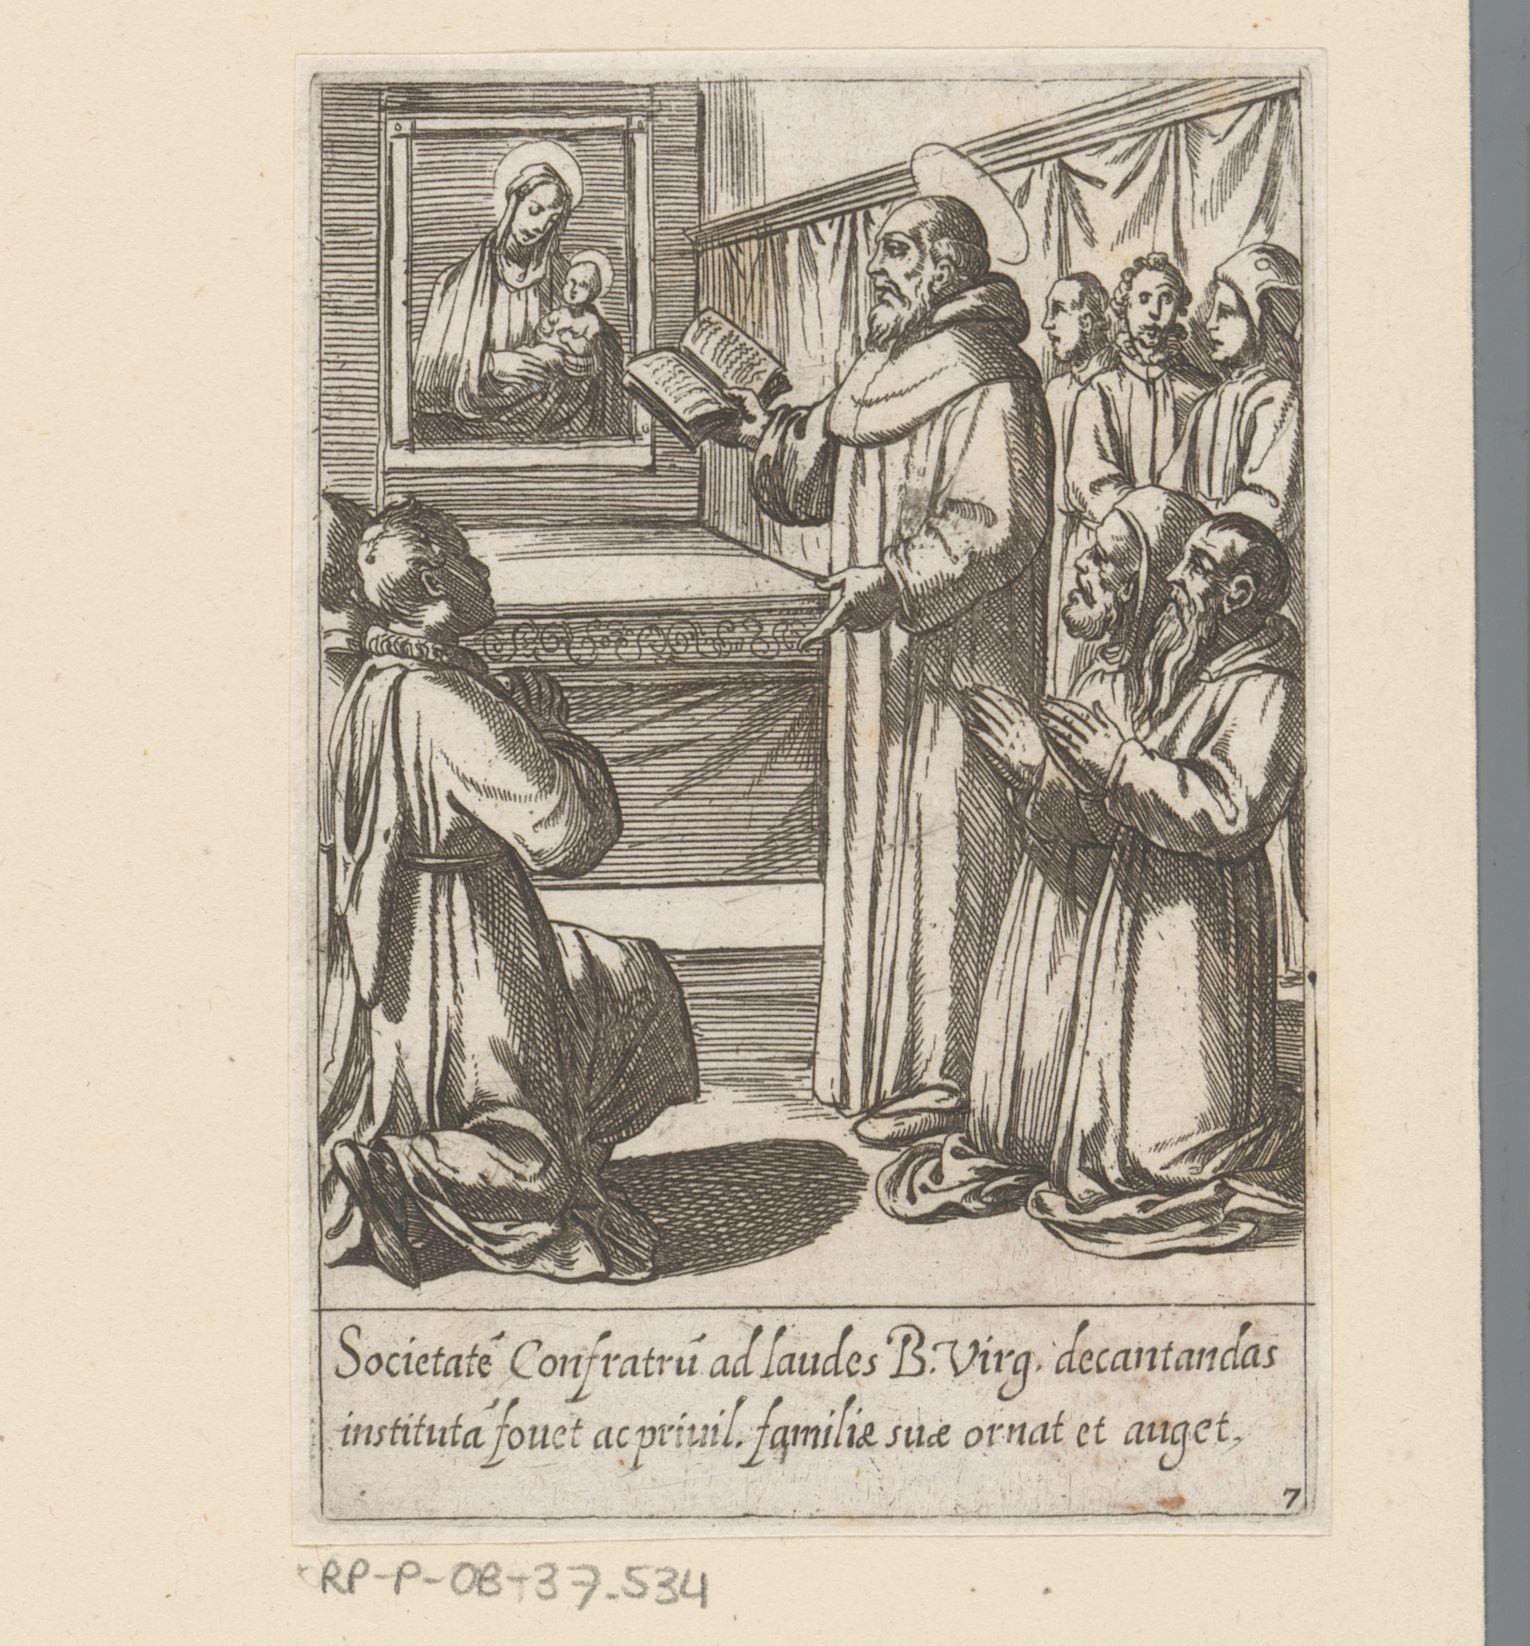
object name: print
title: De heilige Philippus gaat voor in gebed als hoofd van de servieten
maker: antonio tempesta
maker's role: draughtsman, painter, print maker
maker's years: 1555-1630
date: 1591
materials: paper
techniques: etching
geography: vatican city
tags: (public) prayer, prior general of the order of the servites, philip benizzi of florence; possible attributes: book, cross, lily, tiara at his feet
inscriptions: collector's mark: Lugt 240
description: De heilige Philippus gaat voor in gebed als hoofd van de servieten. Tekst in het Latijn in ondermarge. Genummerd rechtsonder: 7.